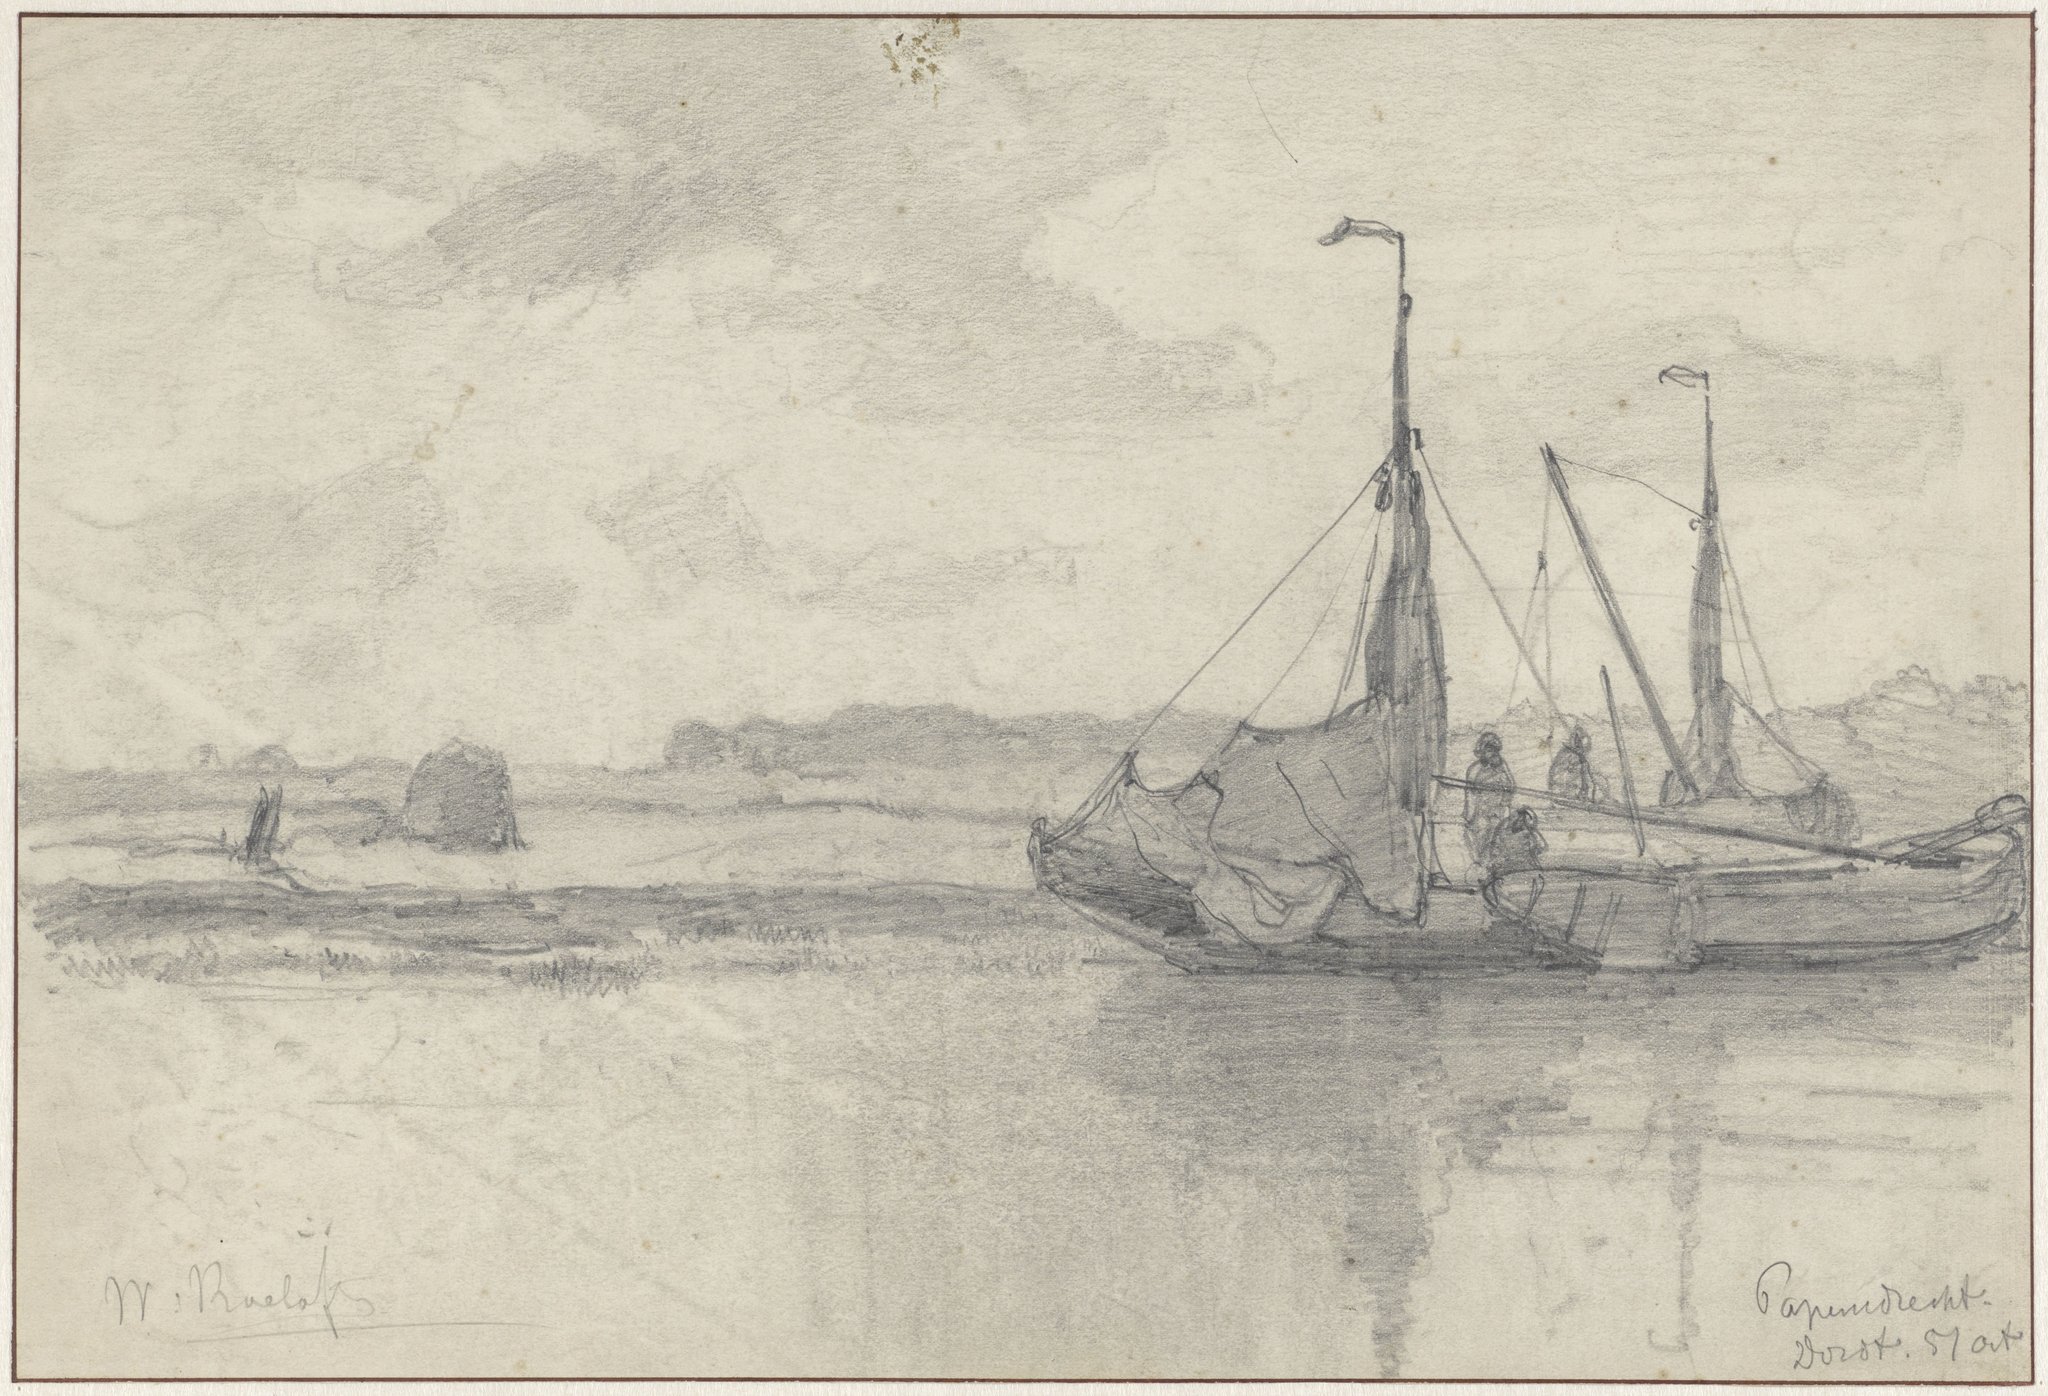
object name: drawing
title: Vissersboten in een landschap te Papendrecht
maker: willem roelofs (i)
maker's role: draughtsman, painter, print maker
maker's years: 1822-1897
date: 1810-1851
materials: paper, pencil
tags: commercial fishery, river, ships (in general)